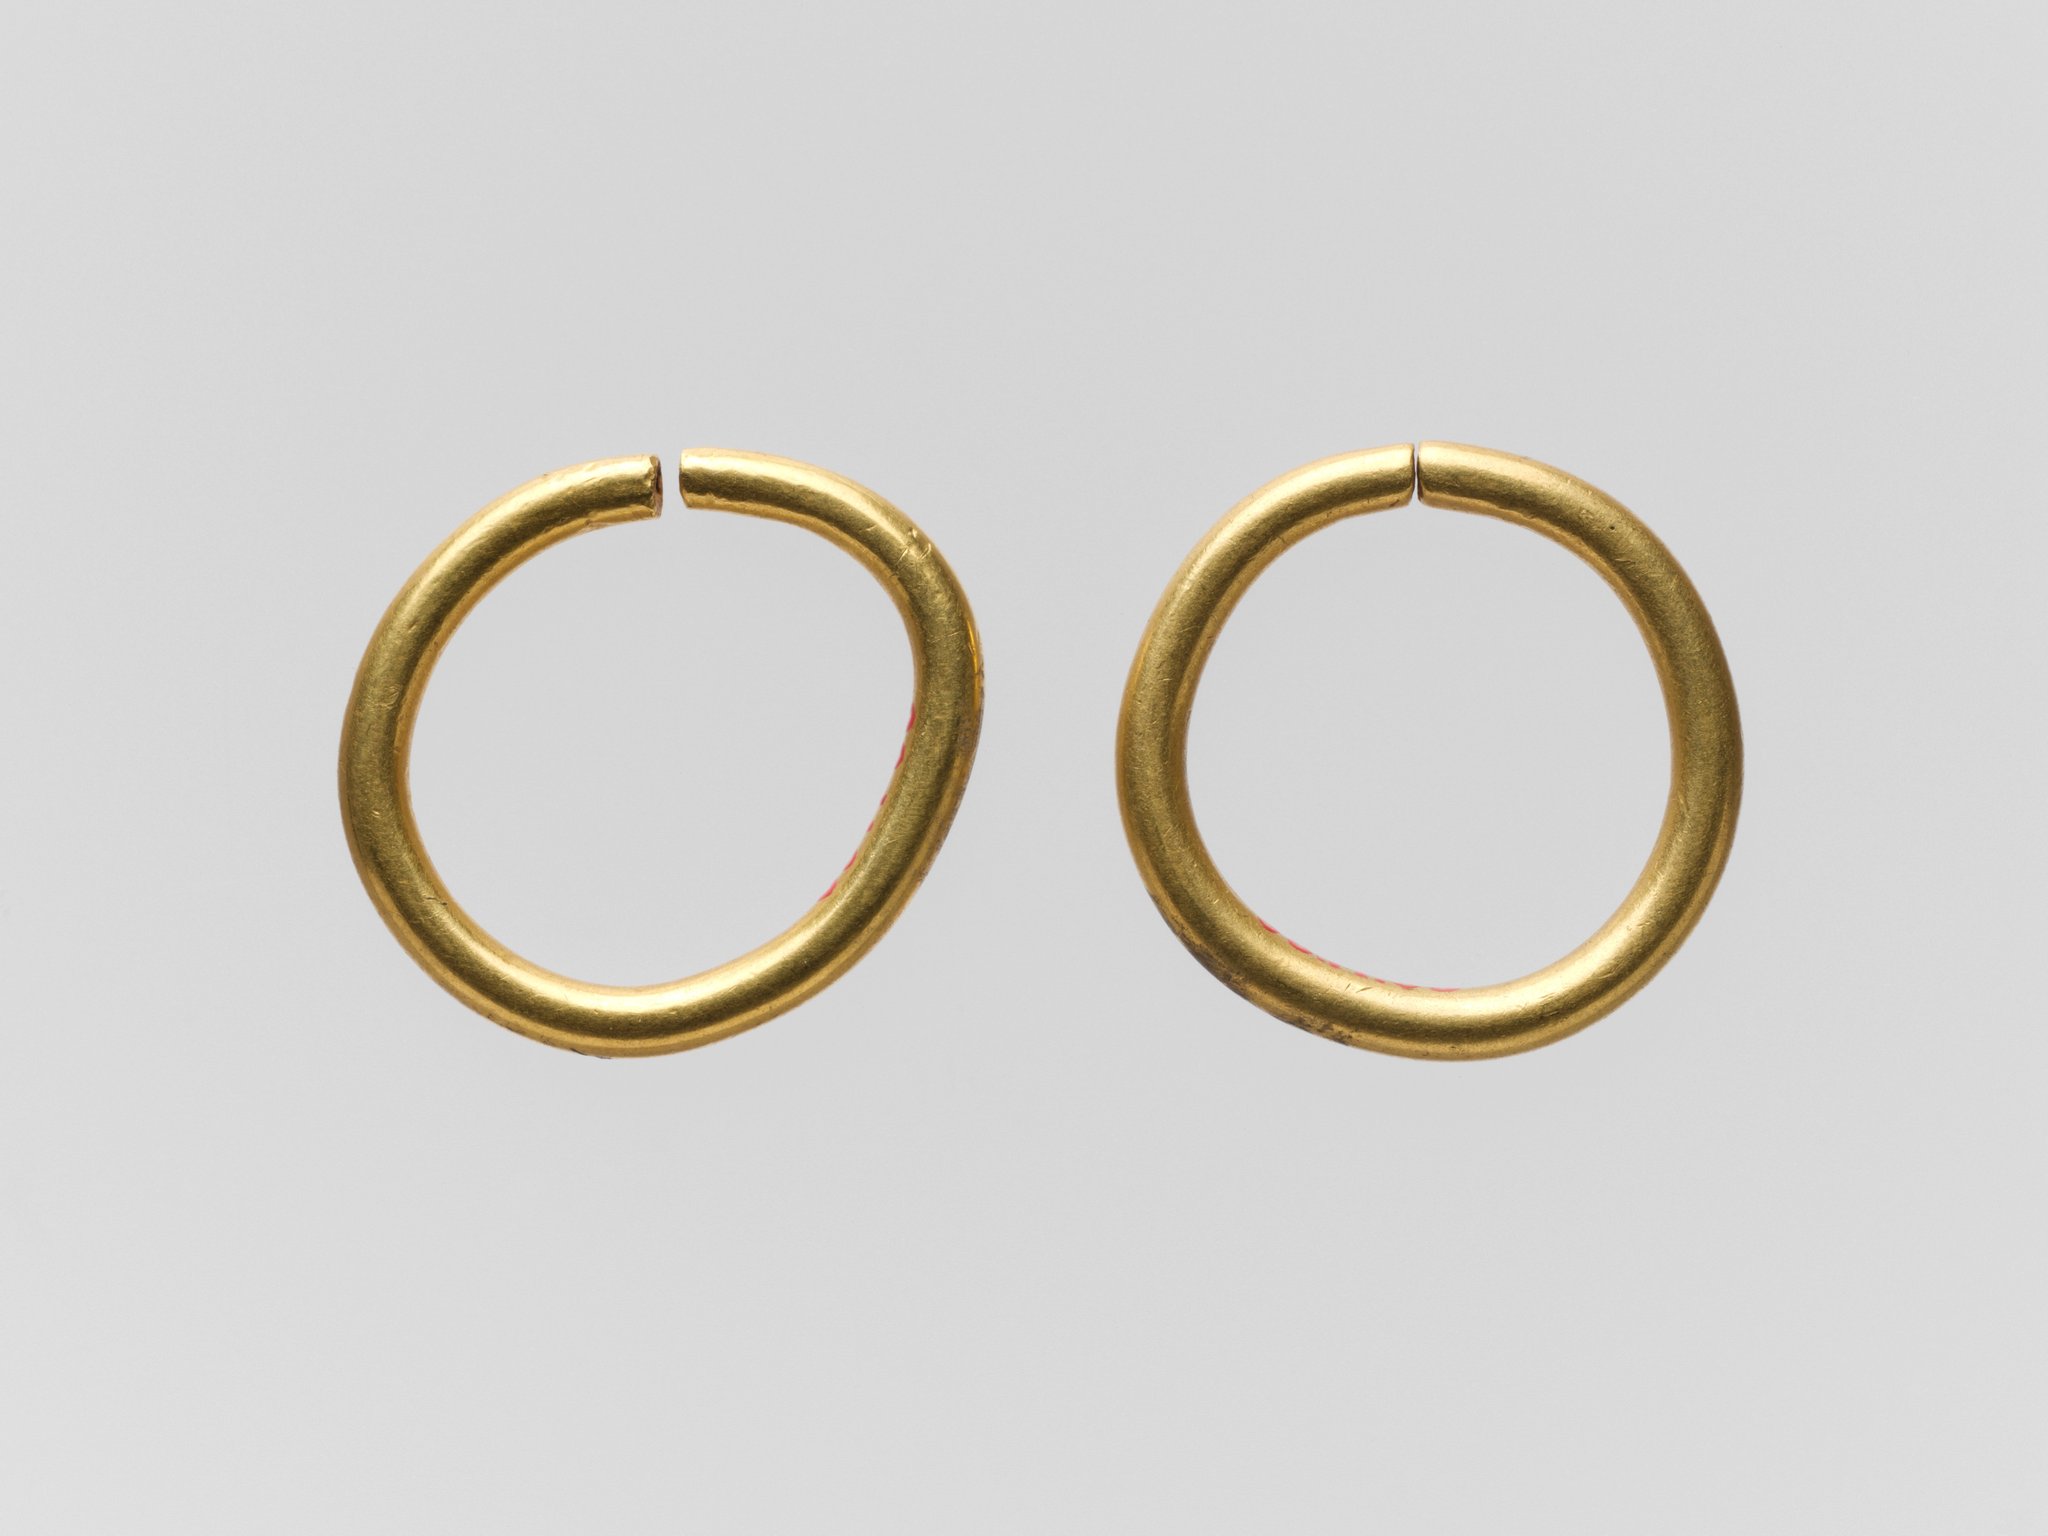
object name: earring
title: Pair of gold earrings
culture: greek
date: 501-600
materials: gold